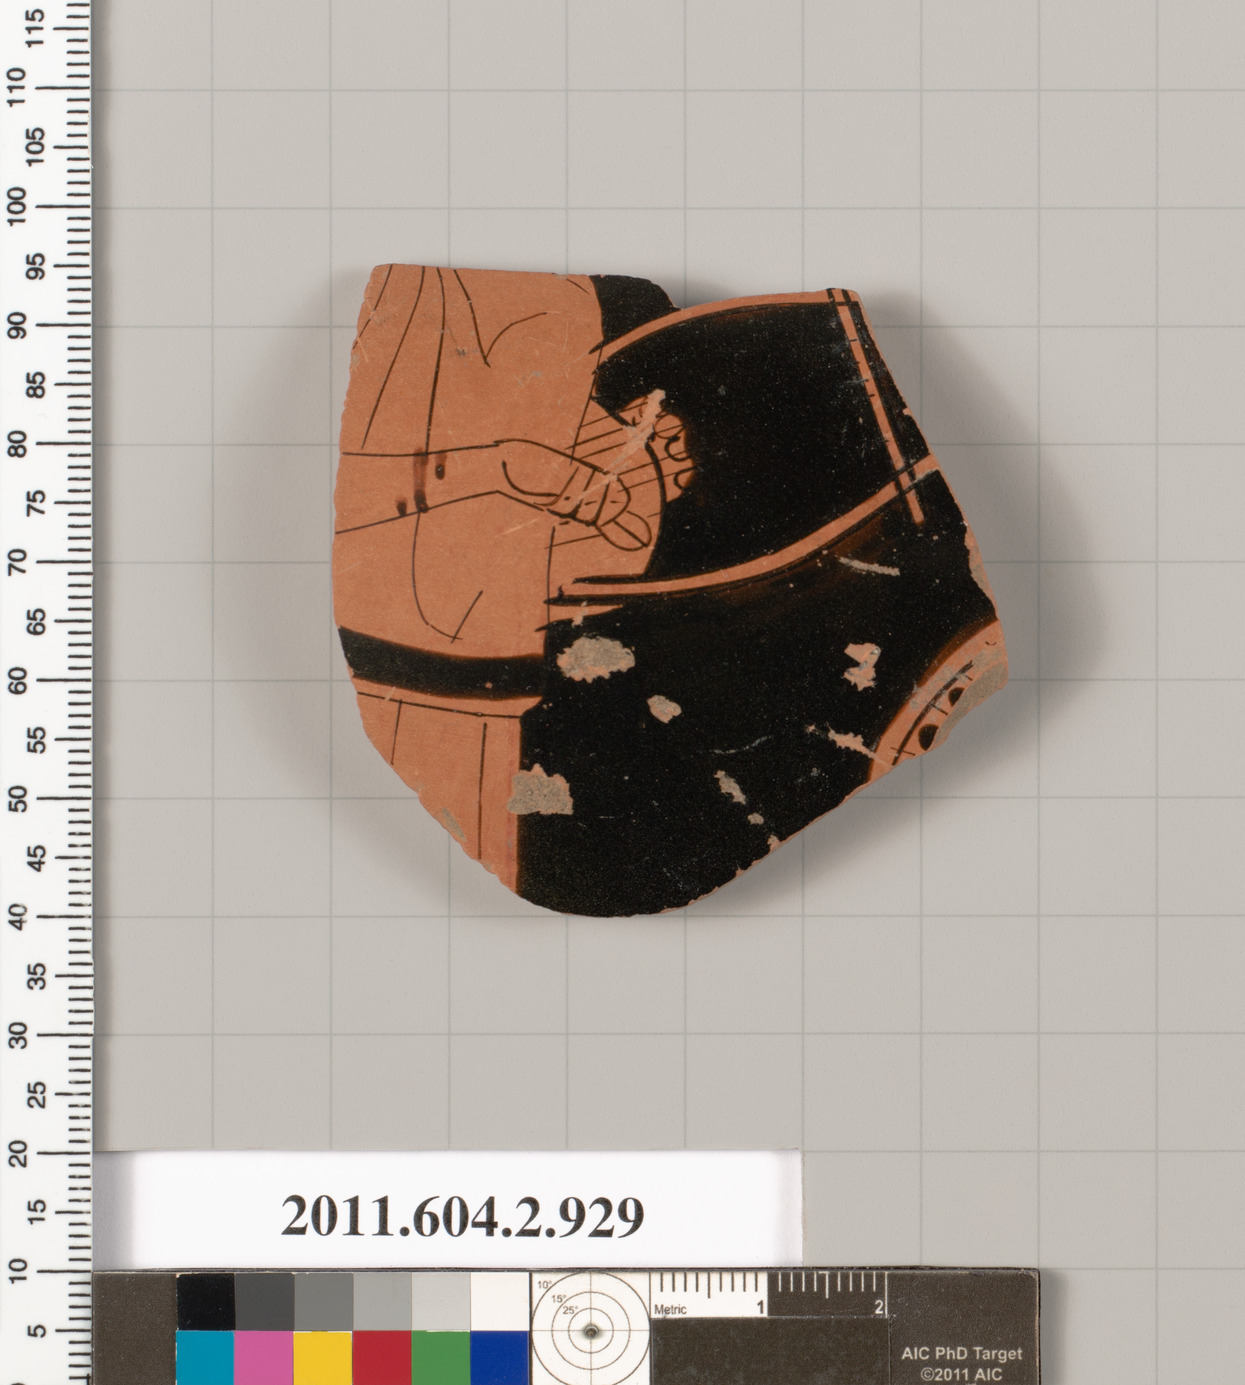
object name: hydria fragment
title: Terracotta fragment of a hydria (water jar)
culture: greek, attic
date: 467-435 BCE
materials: terracotta